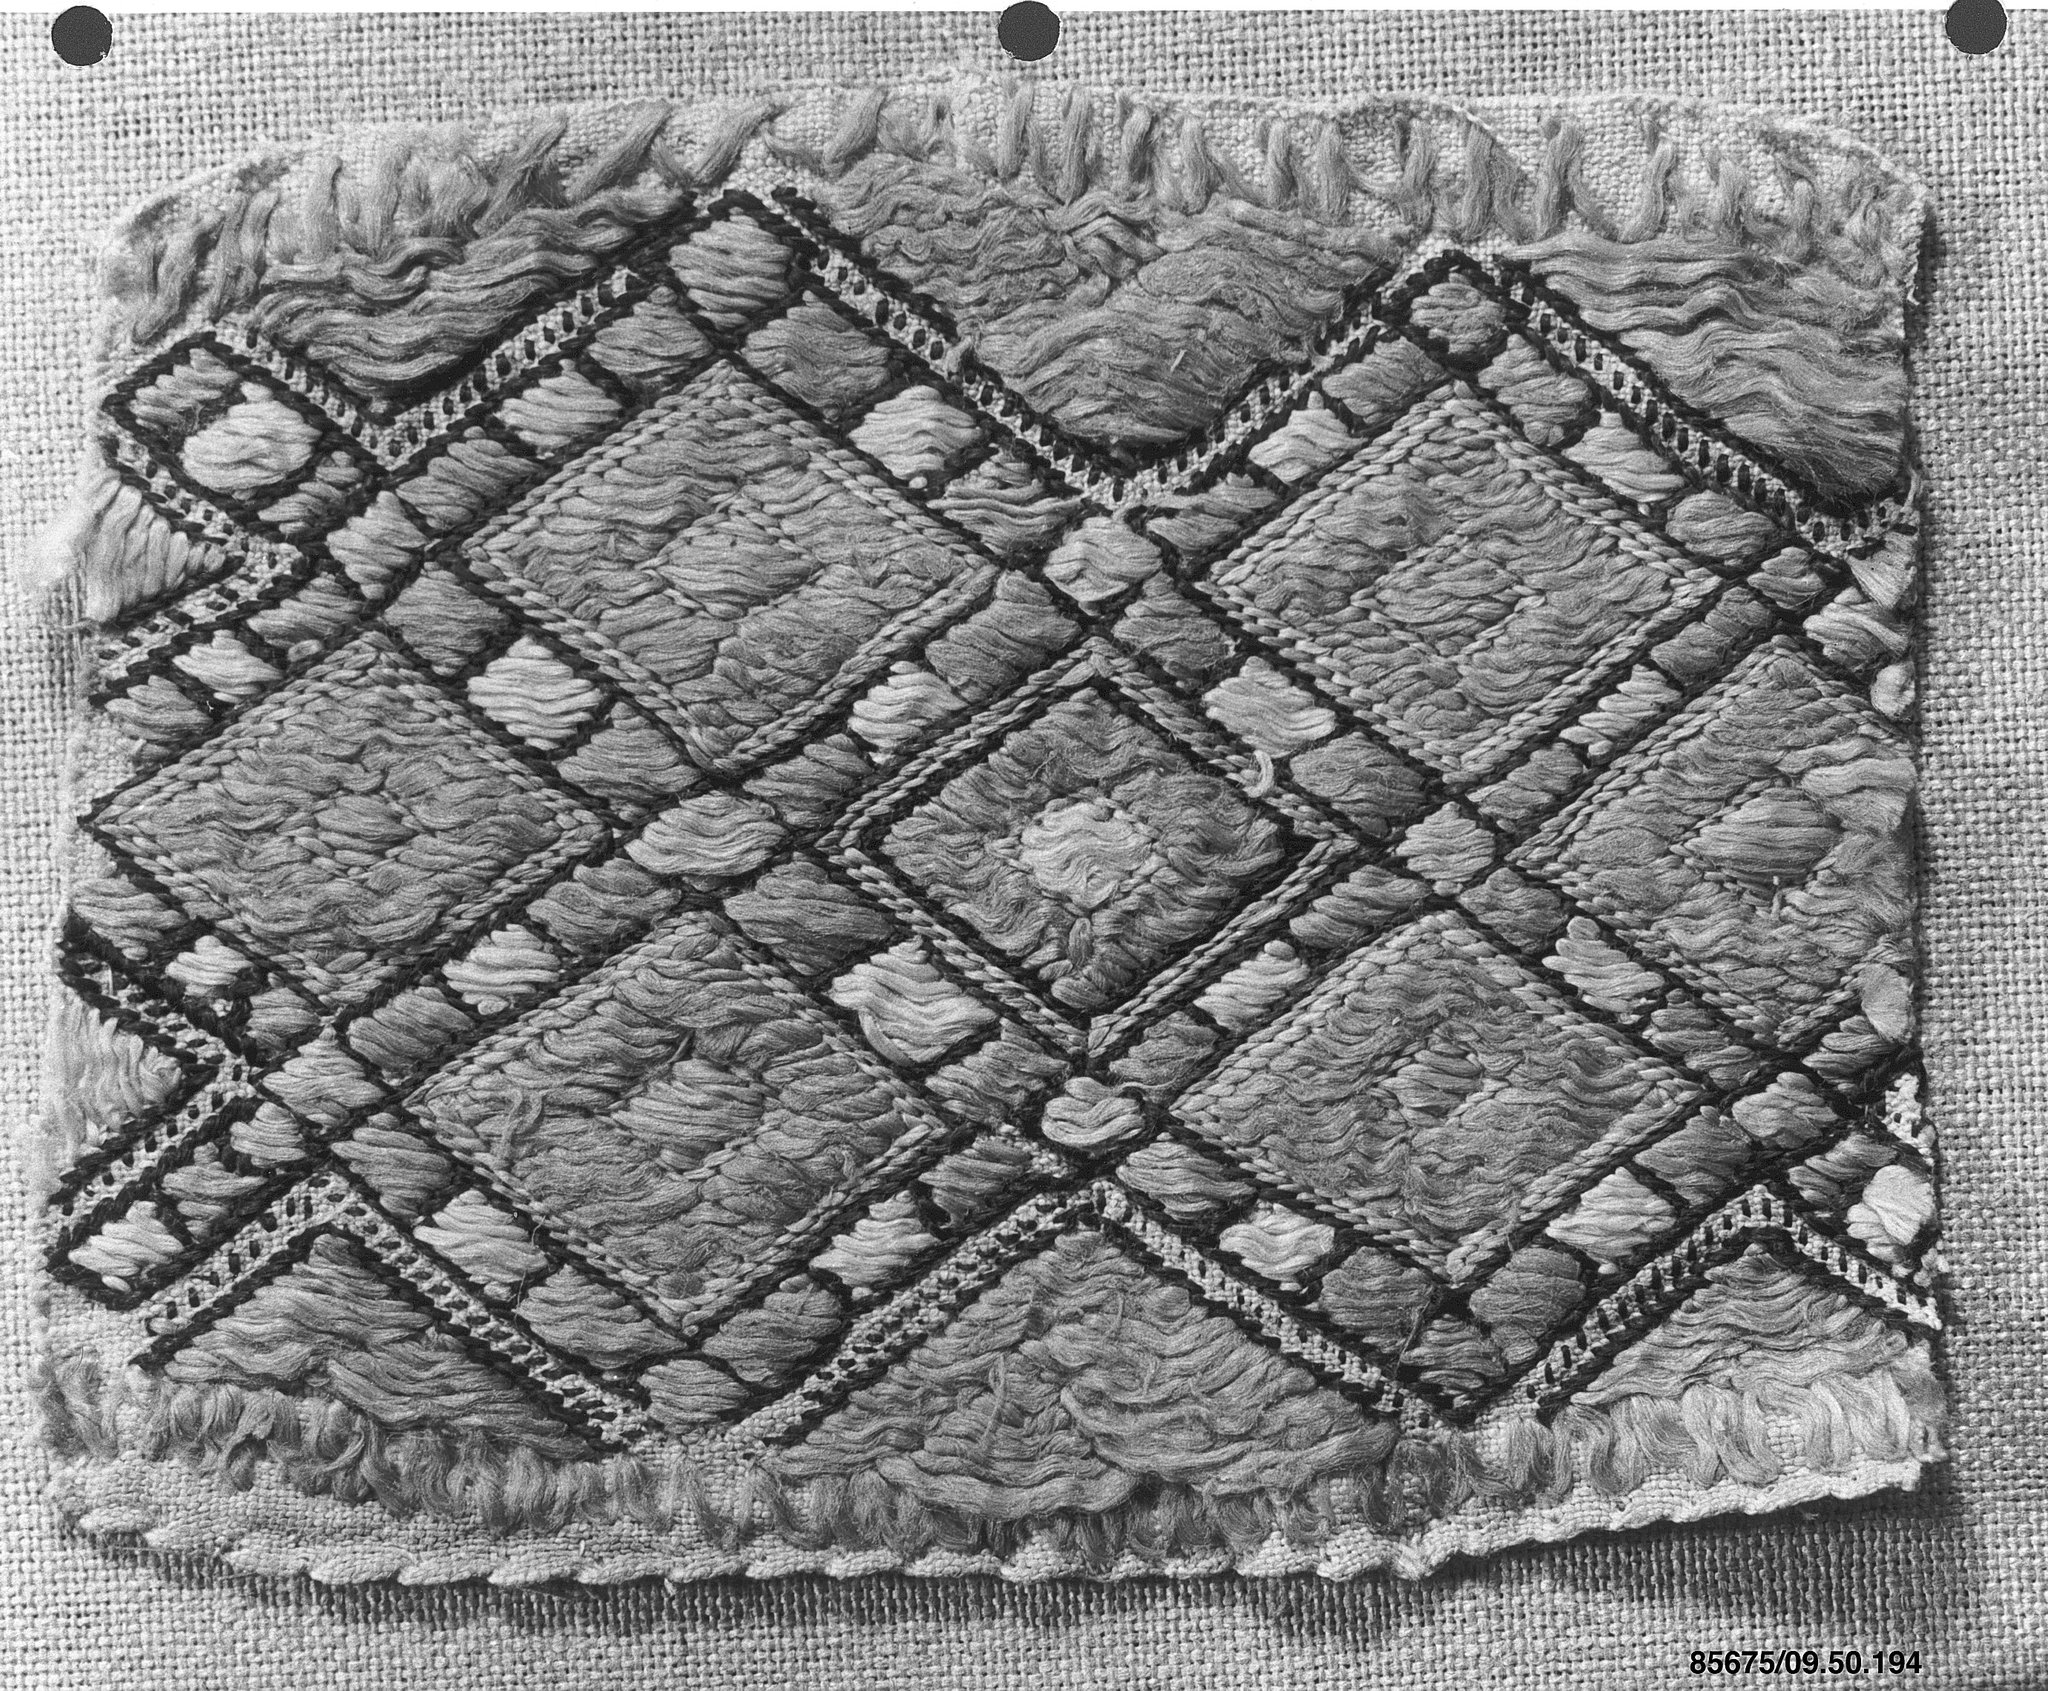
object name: costume fragment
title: Peasant costume fragment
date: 1701-1900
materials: canvas, silk